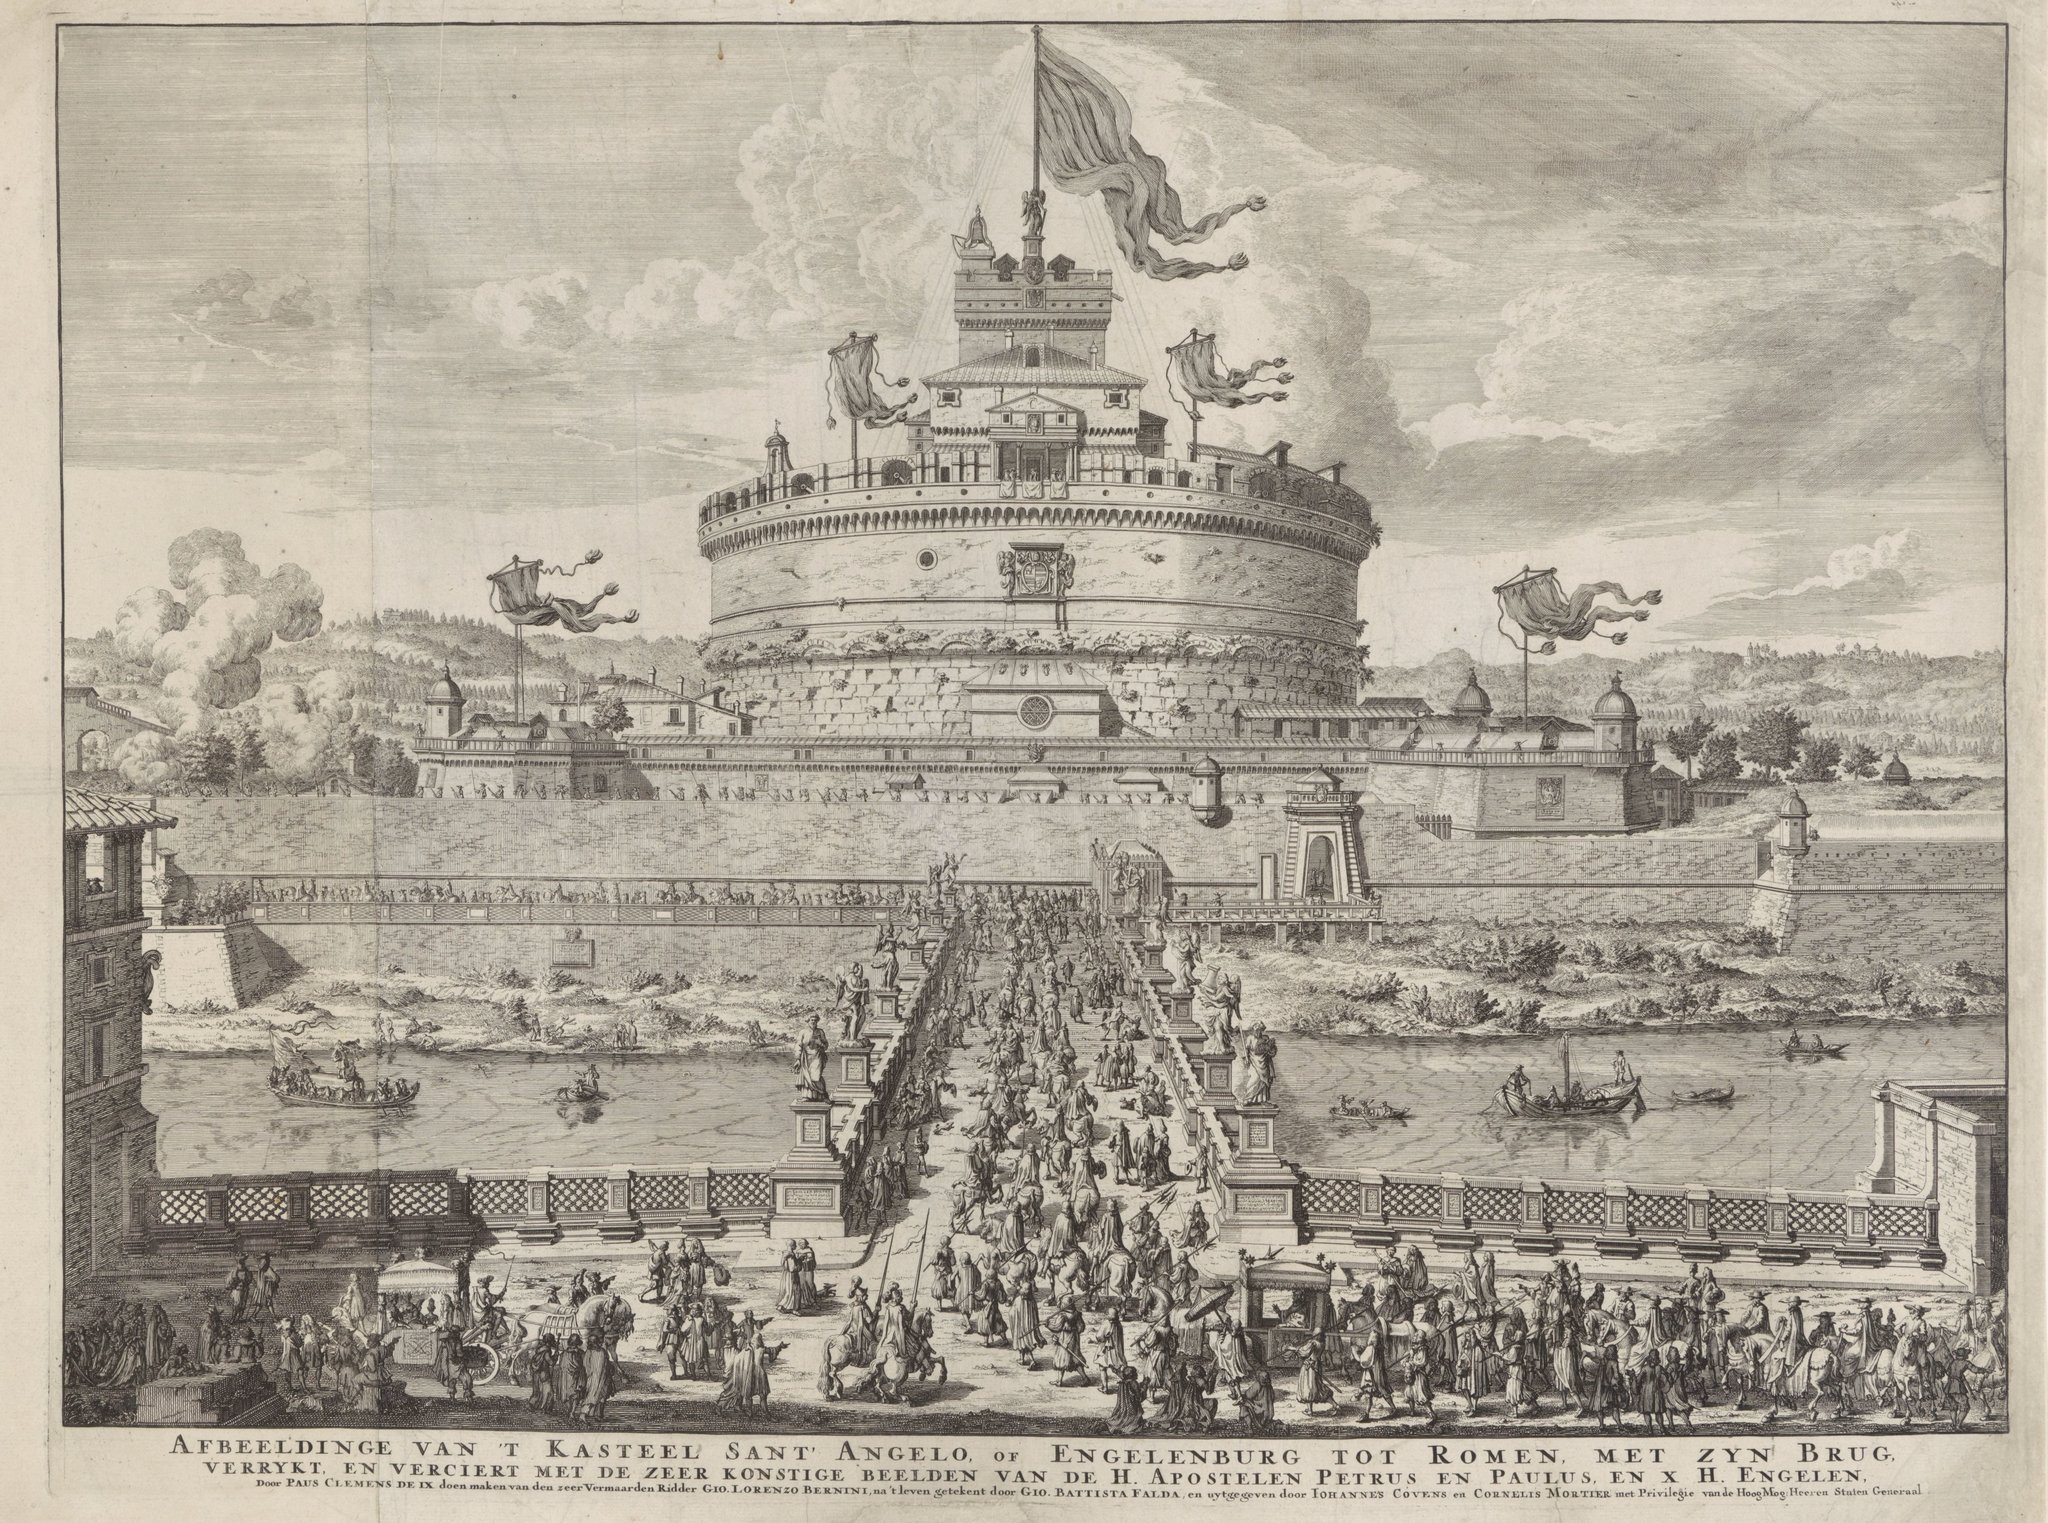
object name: print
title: Engelenburcht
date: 1720-1772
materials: paper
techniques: etching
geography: amsterdam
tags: engelenburcht, engelenbrug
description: Gezicht op de Engelenburcht, in het Italiaans 'Castel Sant' Angelo' genoemd, te Rome. Op de voorgrond trekt een stoet van geestelijken, edellieden en andere figuren over de Engelenbrug richting de Engelenburcht.